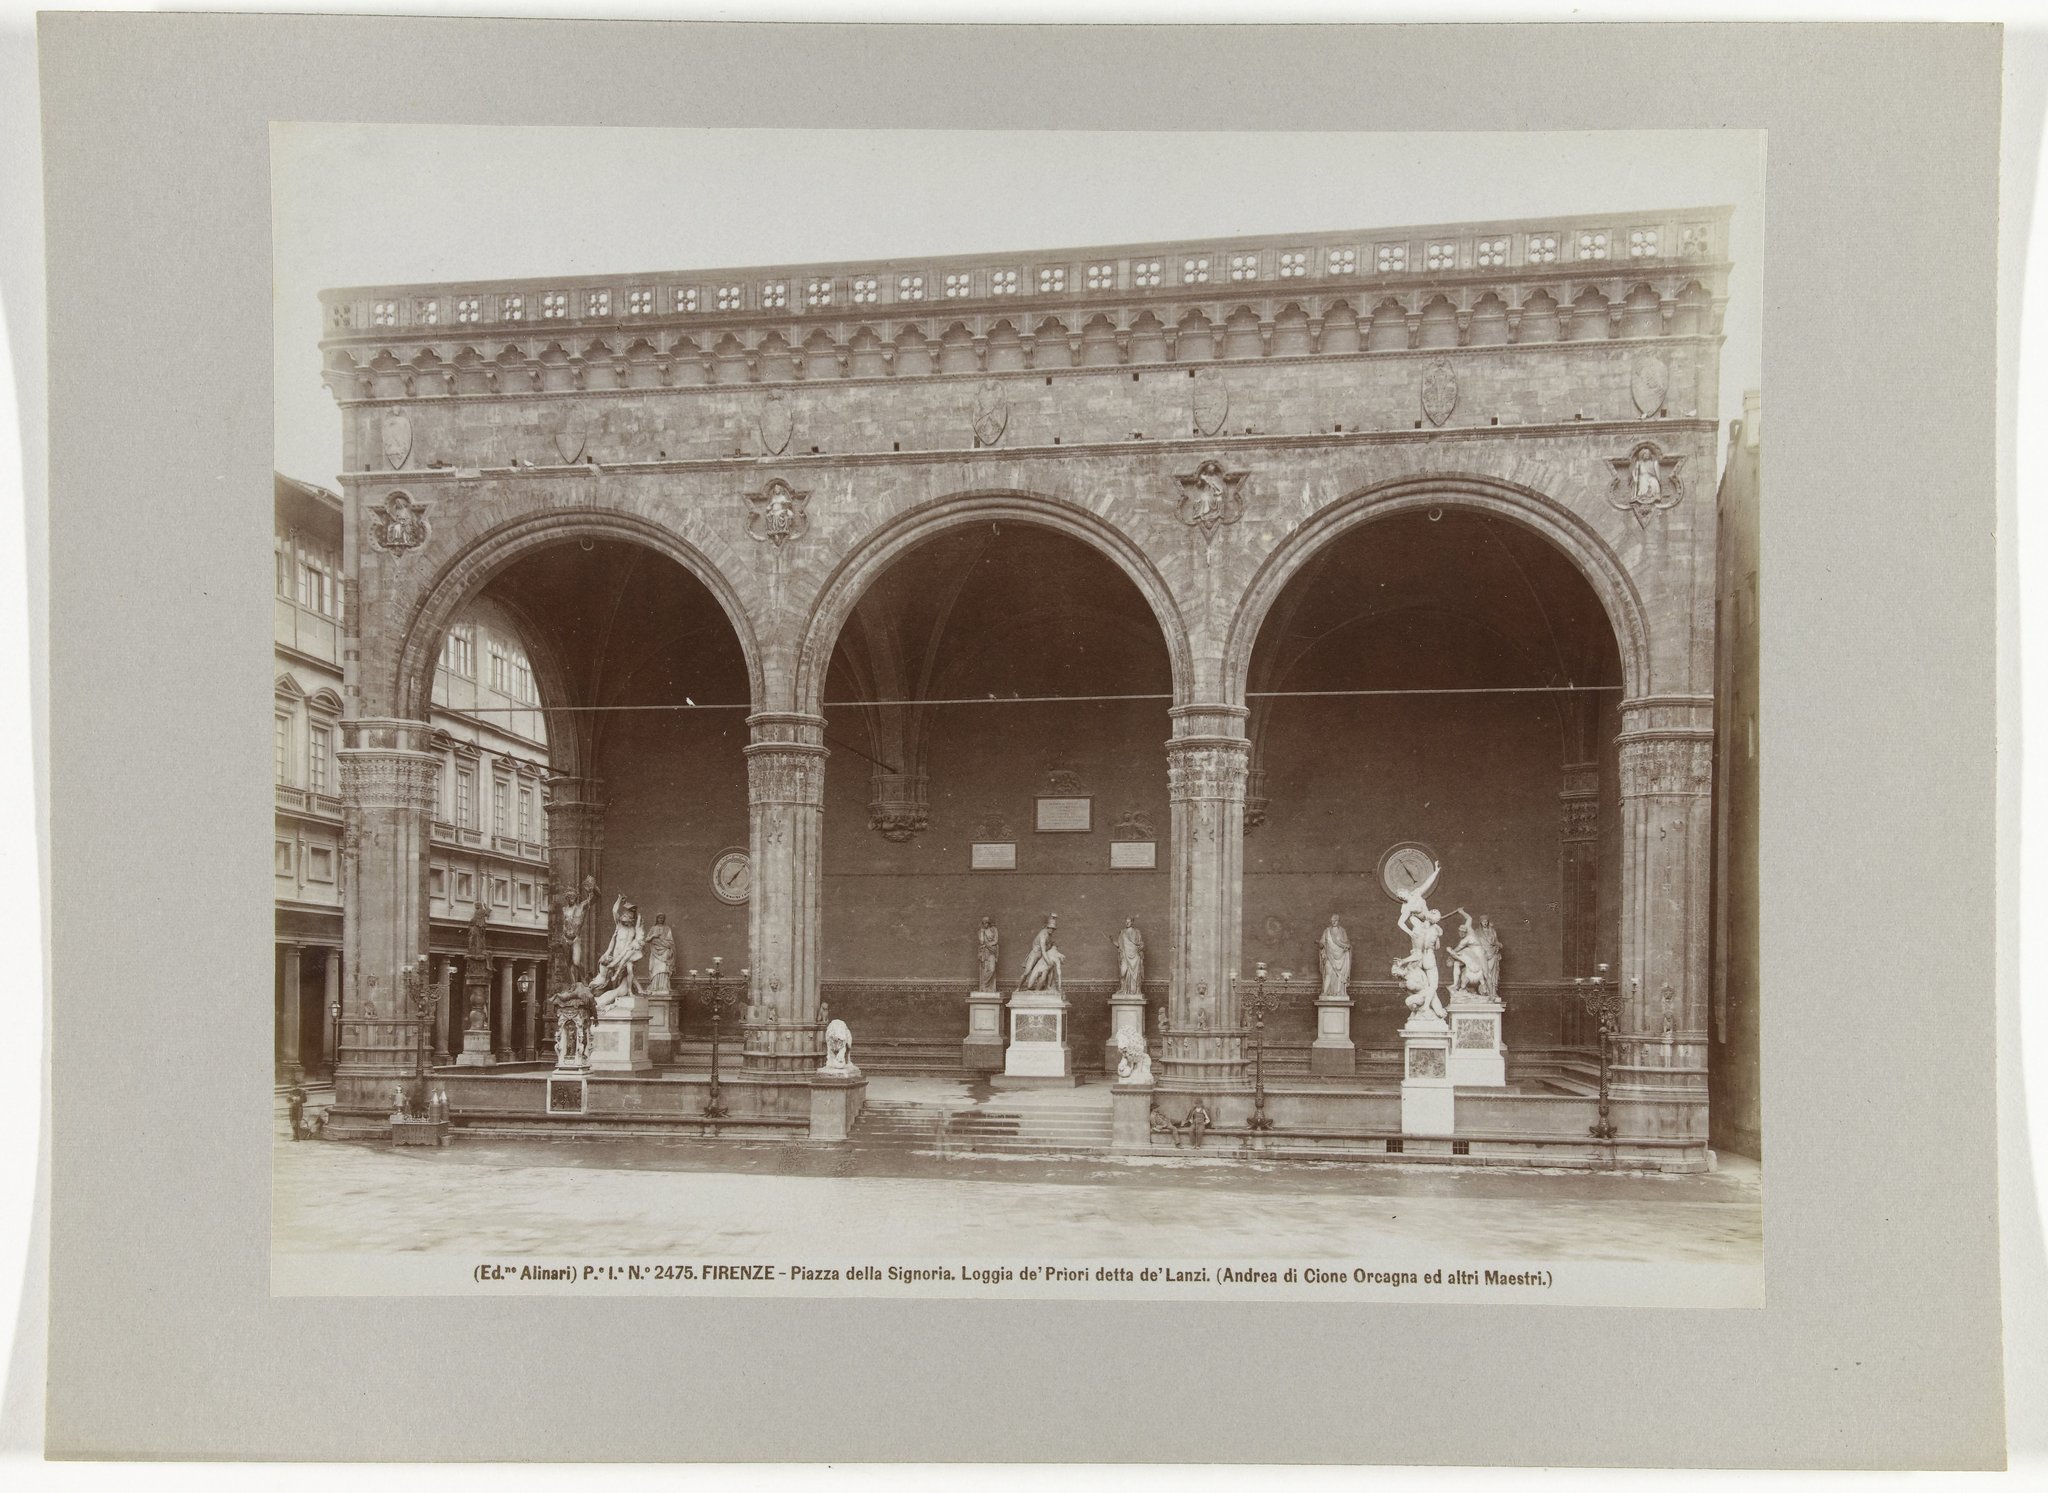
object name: photograph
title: P.e 1.a N.o 2475. FIRENZE - Piazza della Signoria. Loggia de' Priori detta de' Lanzi. (Andrea di Cione Orcagna ed altri Maestri.)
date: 1880-1895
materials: cardboard, paper, photographic support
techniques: albumen print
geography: florence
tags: piece of sculpture, reproduction of a piece of sculpture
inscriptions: number: ‘73.’